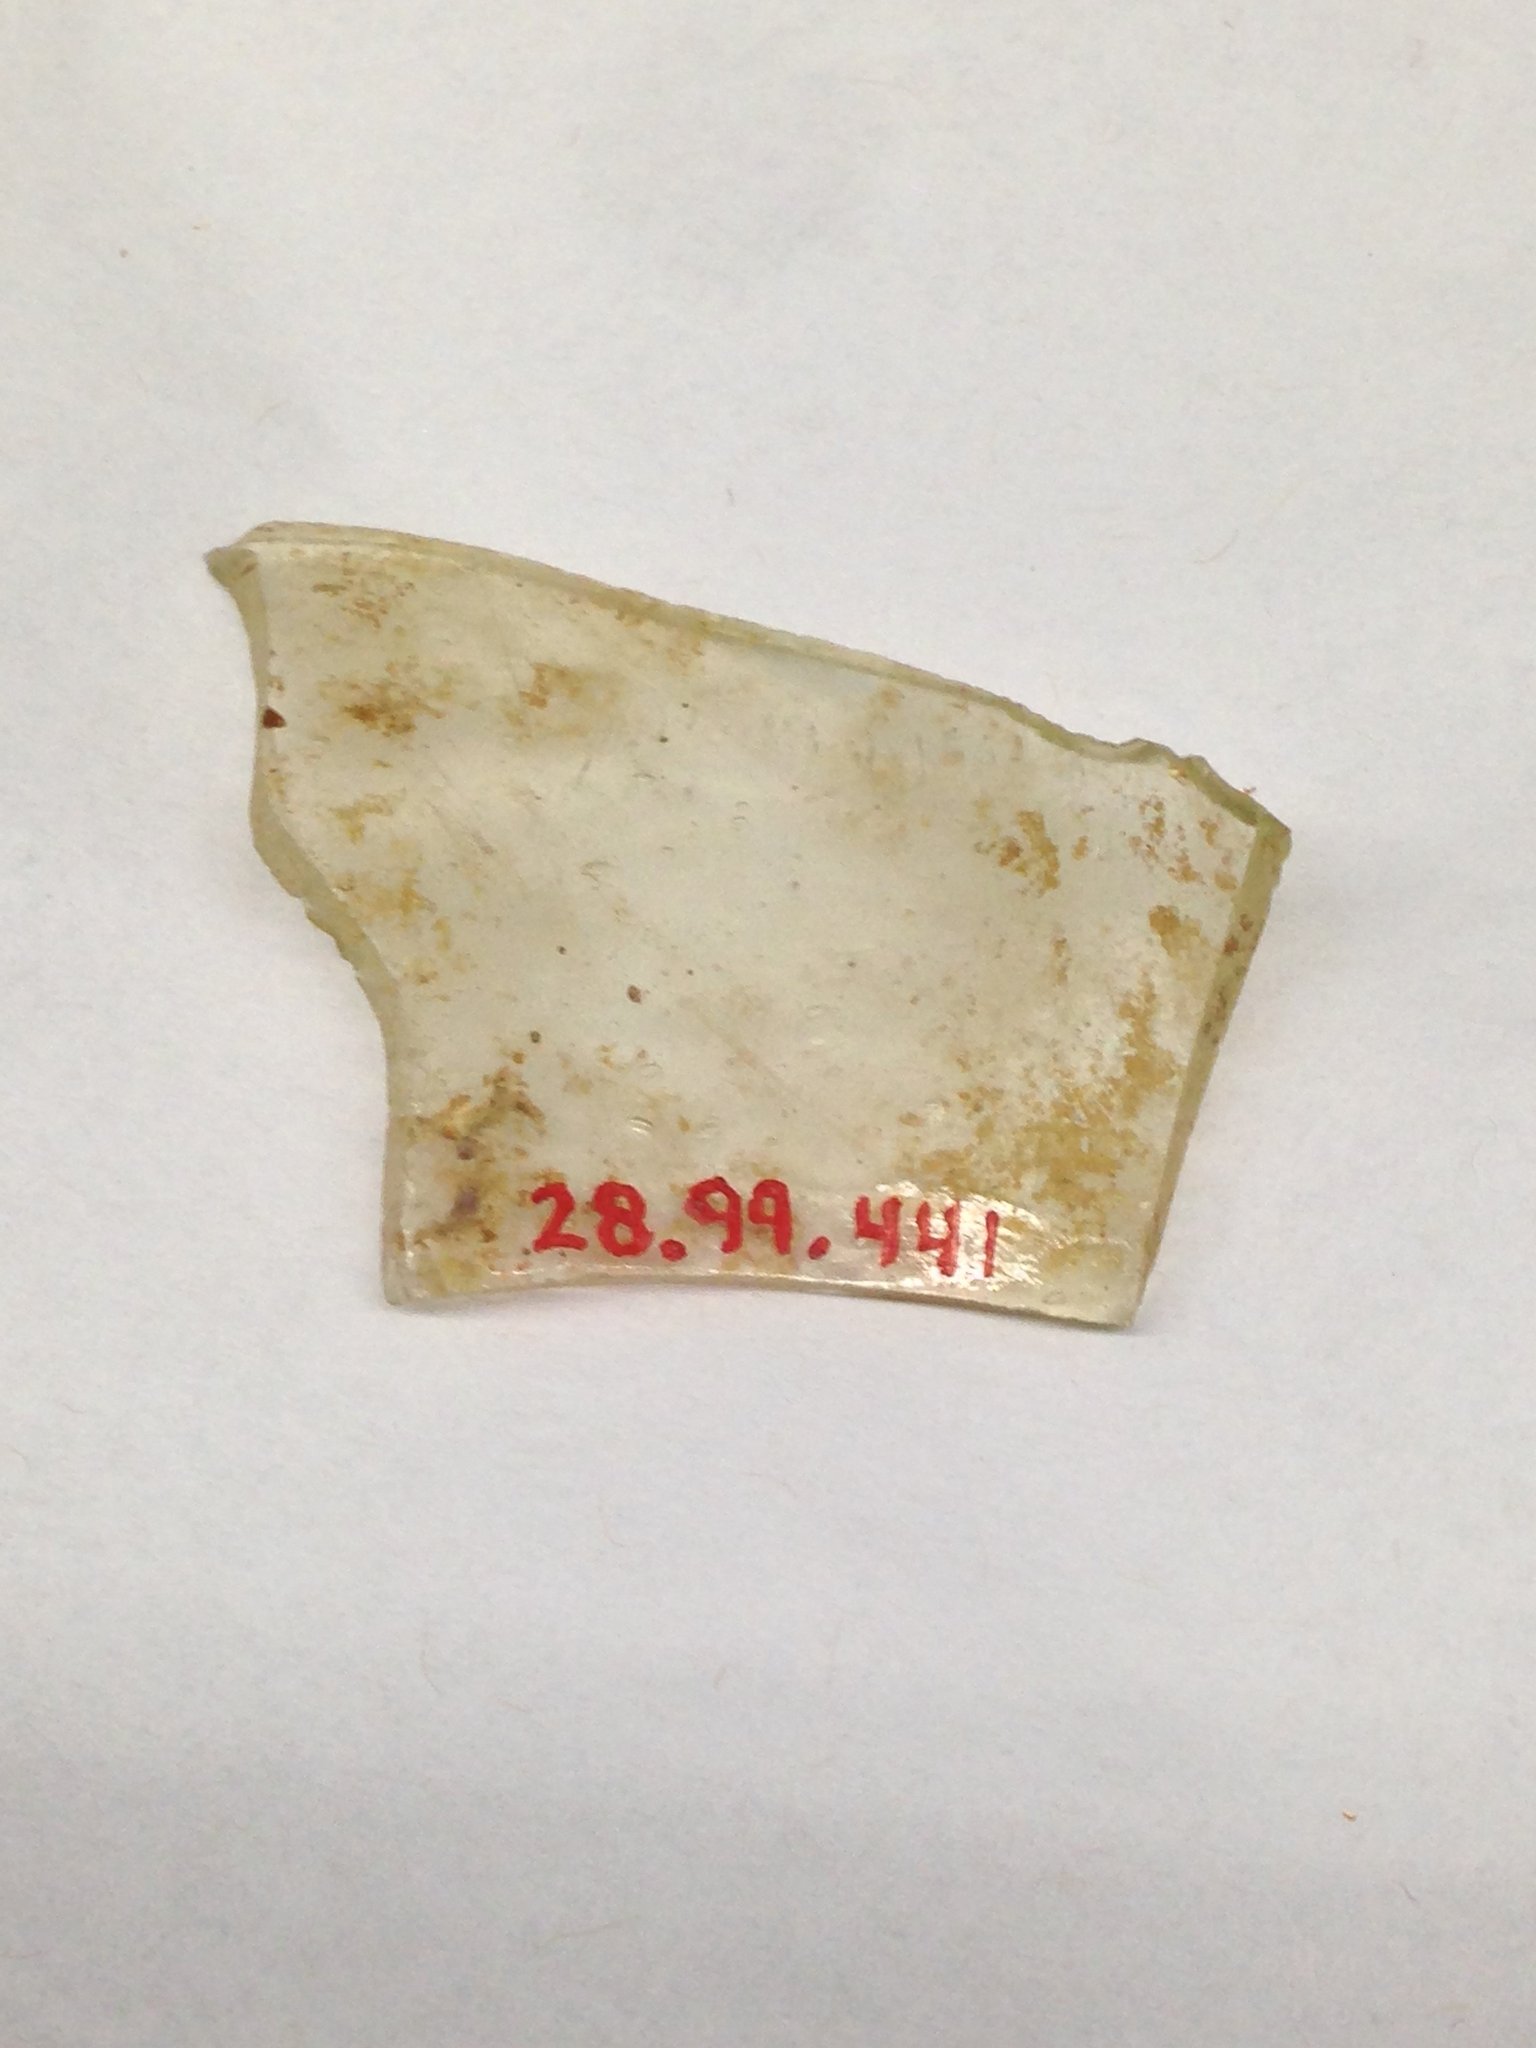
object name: fragment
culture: european or middle eastern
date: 1150-1250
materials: ceramic, glass